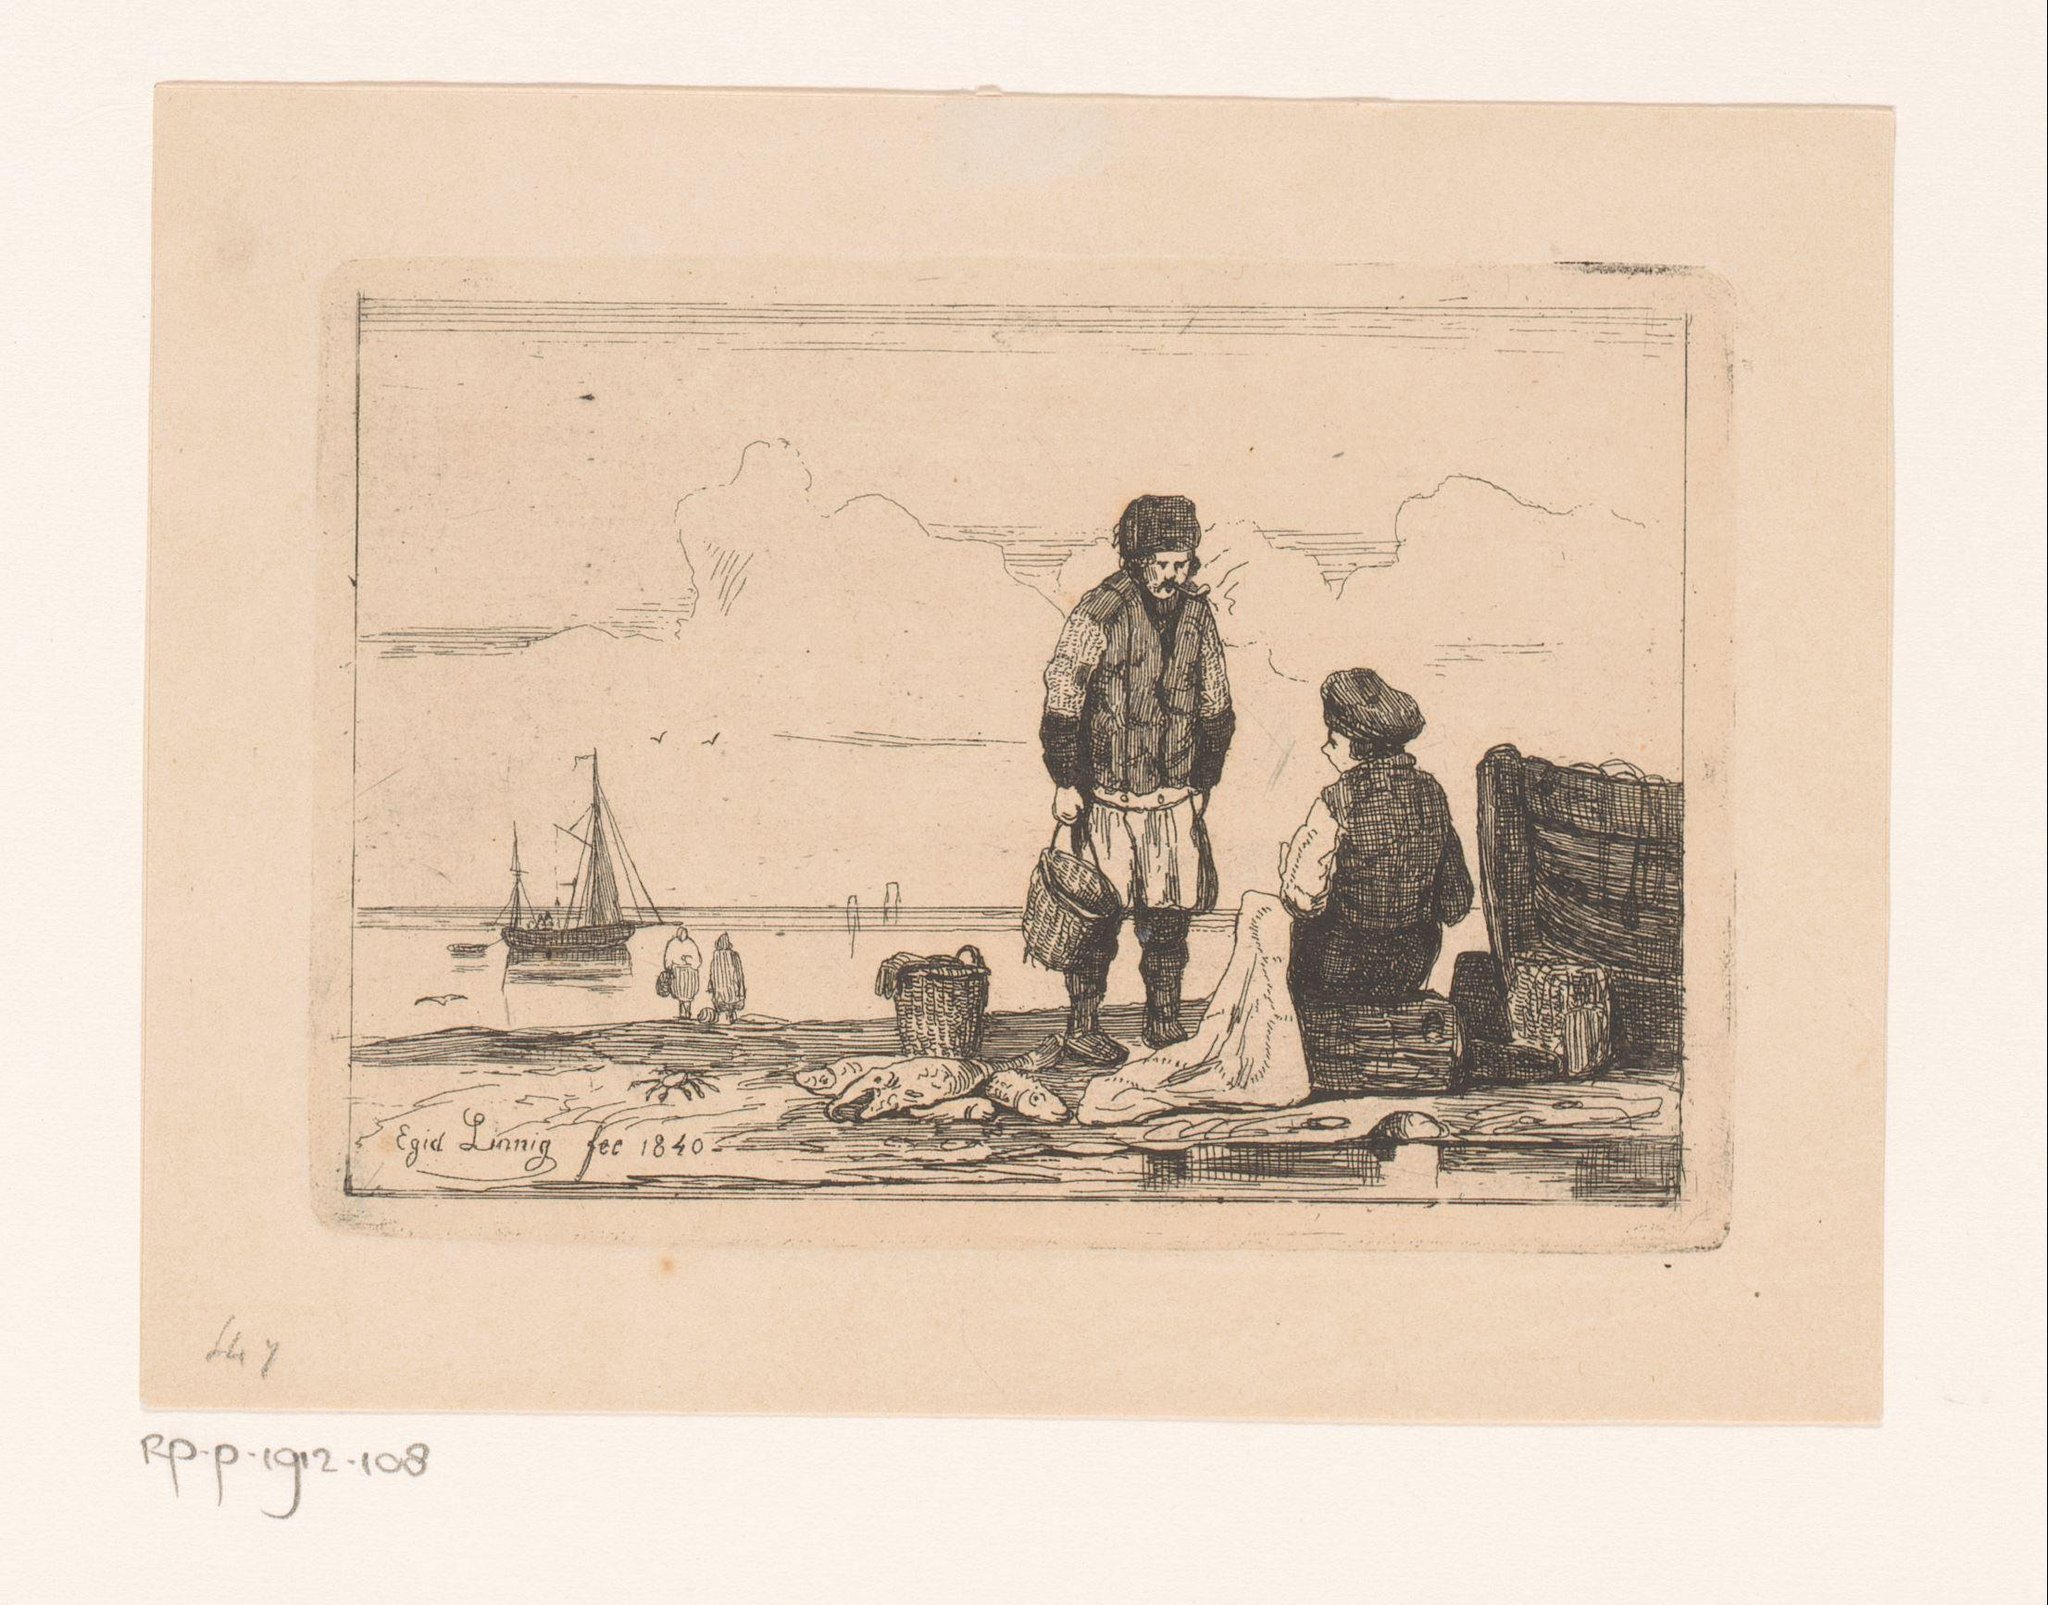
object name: print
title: Twee vissers aan het strand, de een repareert een zeil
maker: egidius linnig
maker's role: draughtsman, print maker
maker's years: 1821-1860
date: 1840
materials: paper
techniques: etching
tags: beach, fisherman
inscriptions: collector's mark: Lugt 1485, collector's mark: Lugt 2228